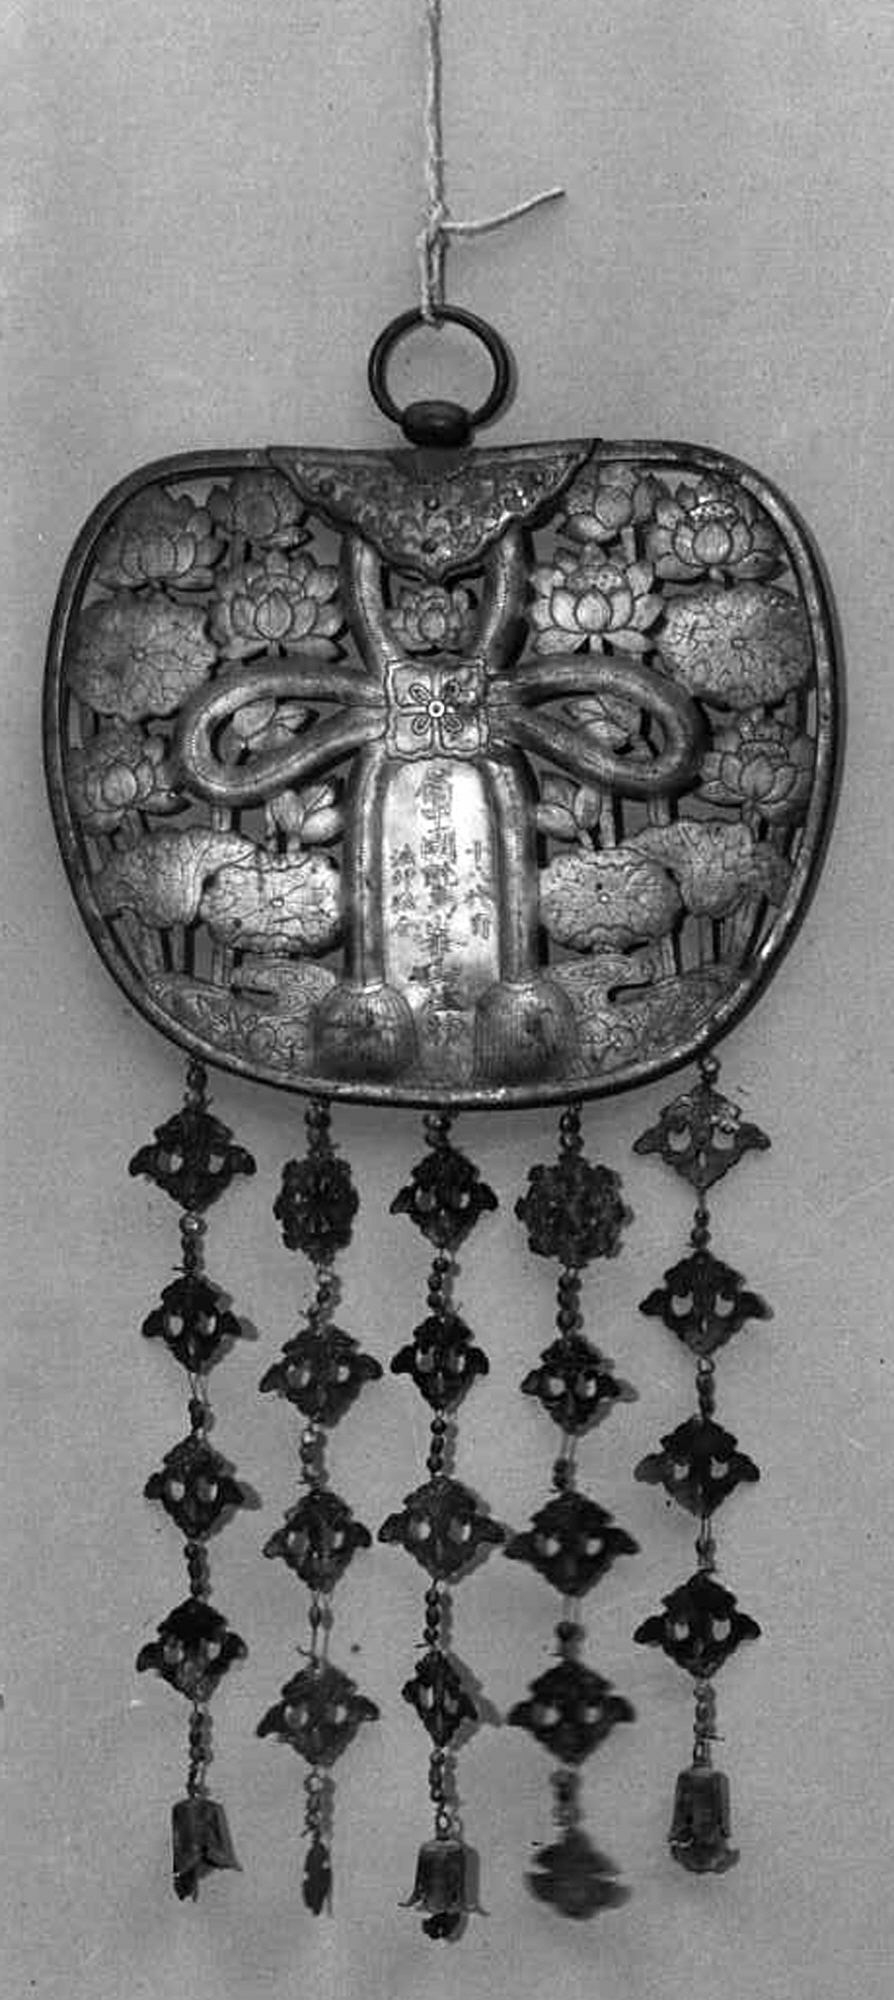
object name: temple decoration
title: Keman (“Flower Garland” Temple Decoration)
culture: japanese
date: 1725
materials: bronze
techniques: gilding